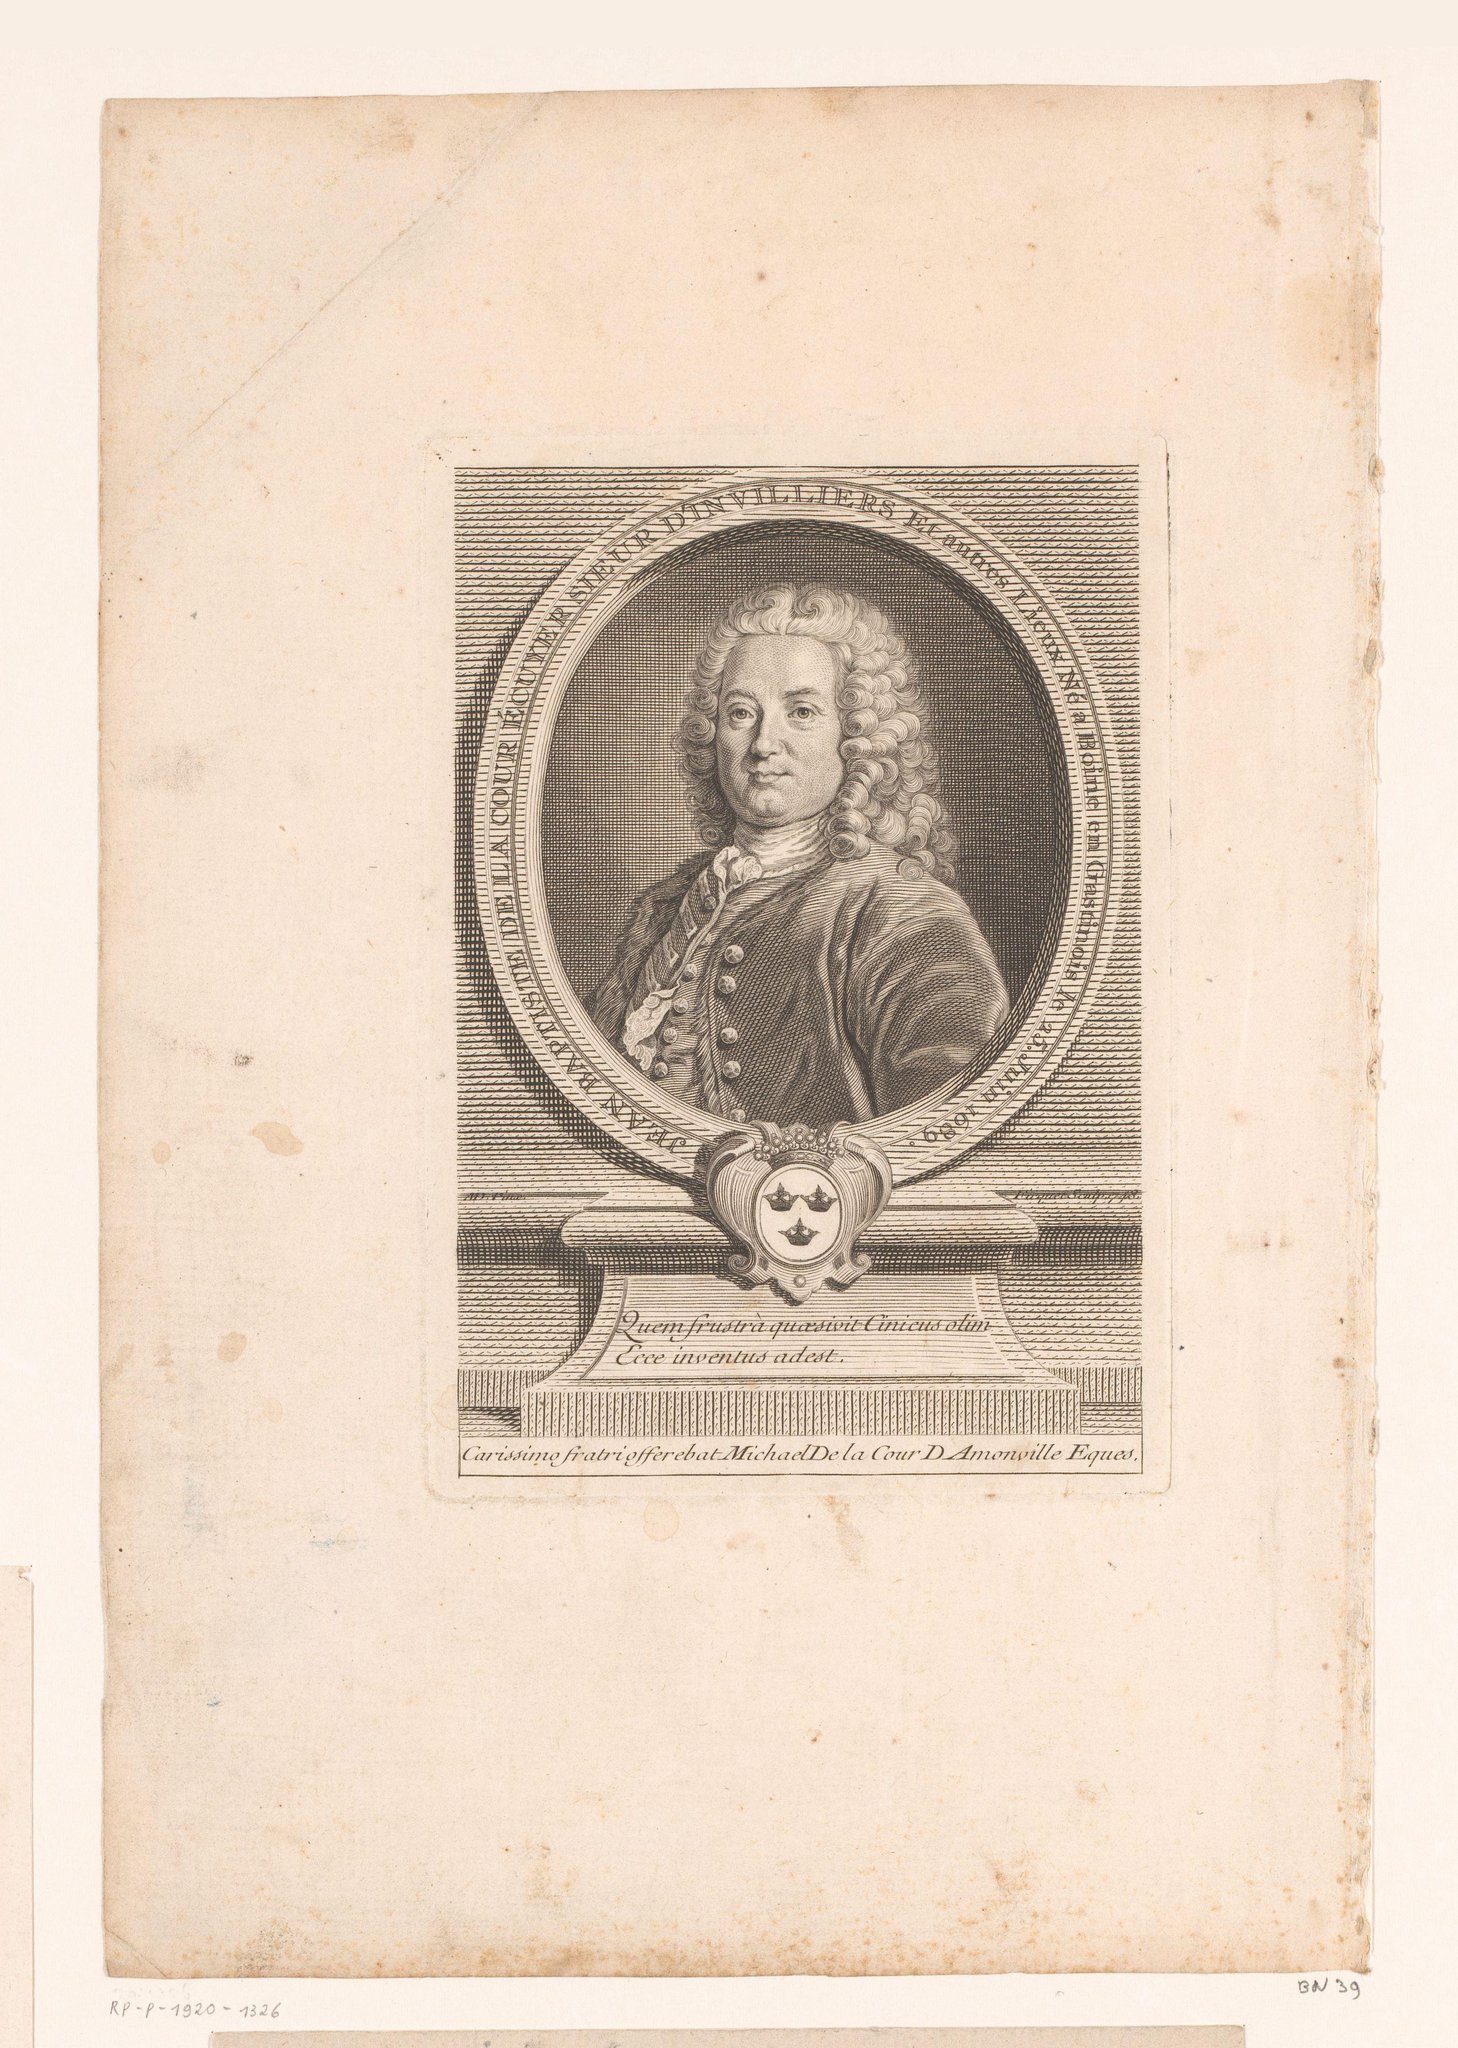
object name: print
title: Jean Baptiste de la Cour écuyer steur d'invilliers (...)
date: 1748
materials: paper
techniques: engraving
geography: france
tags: ornament ~ medallion, historical persons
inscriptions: collector's mark: Lugt 2228